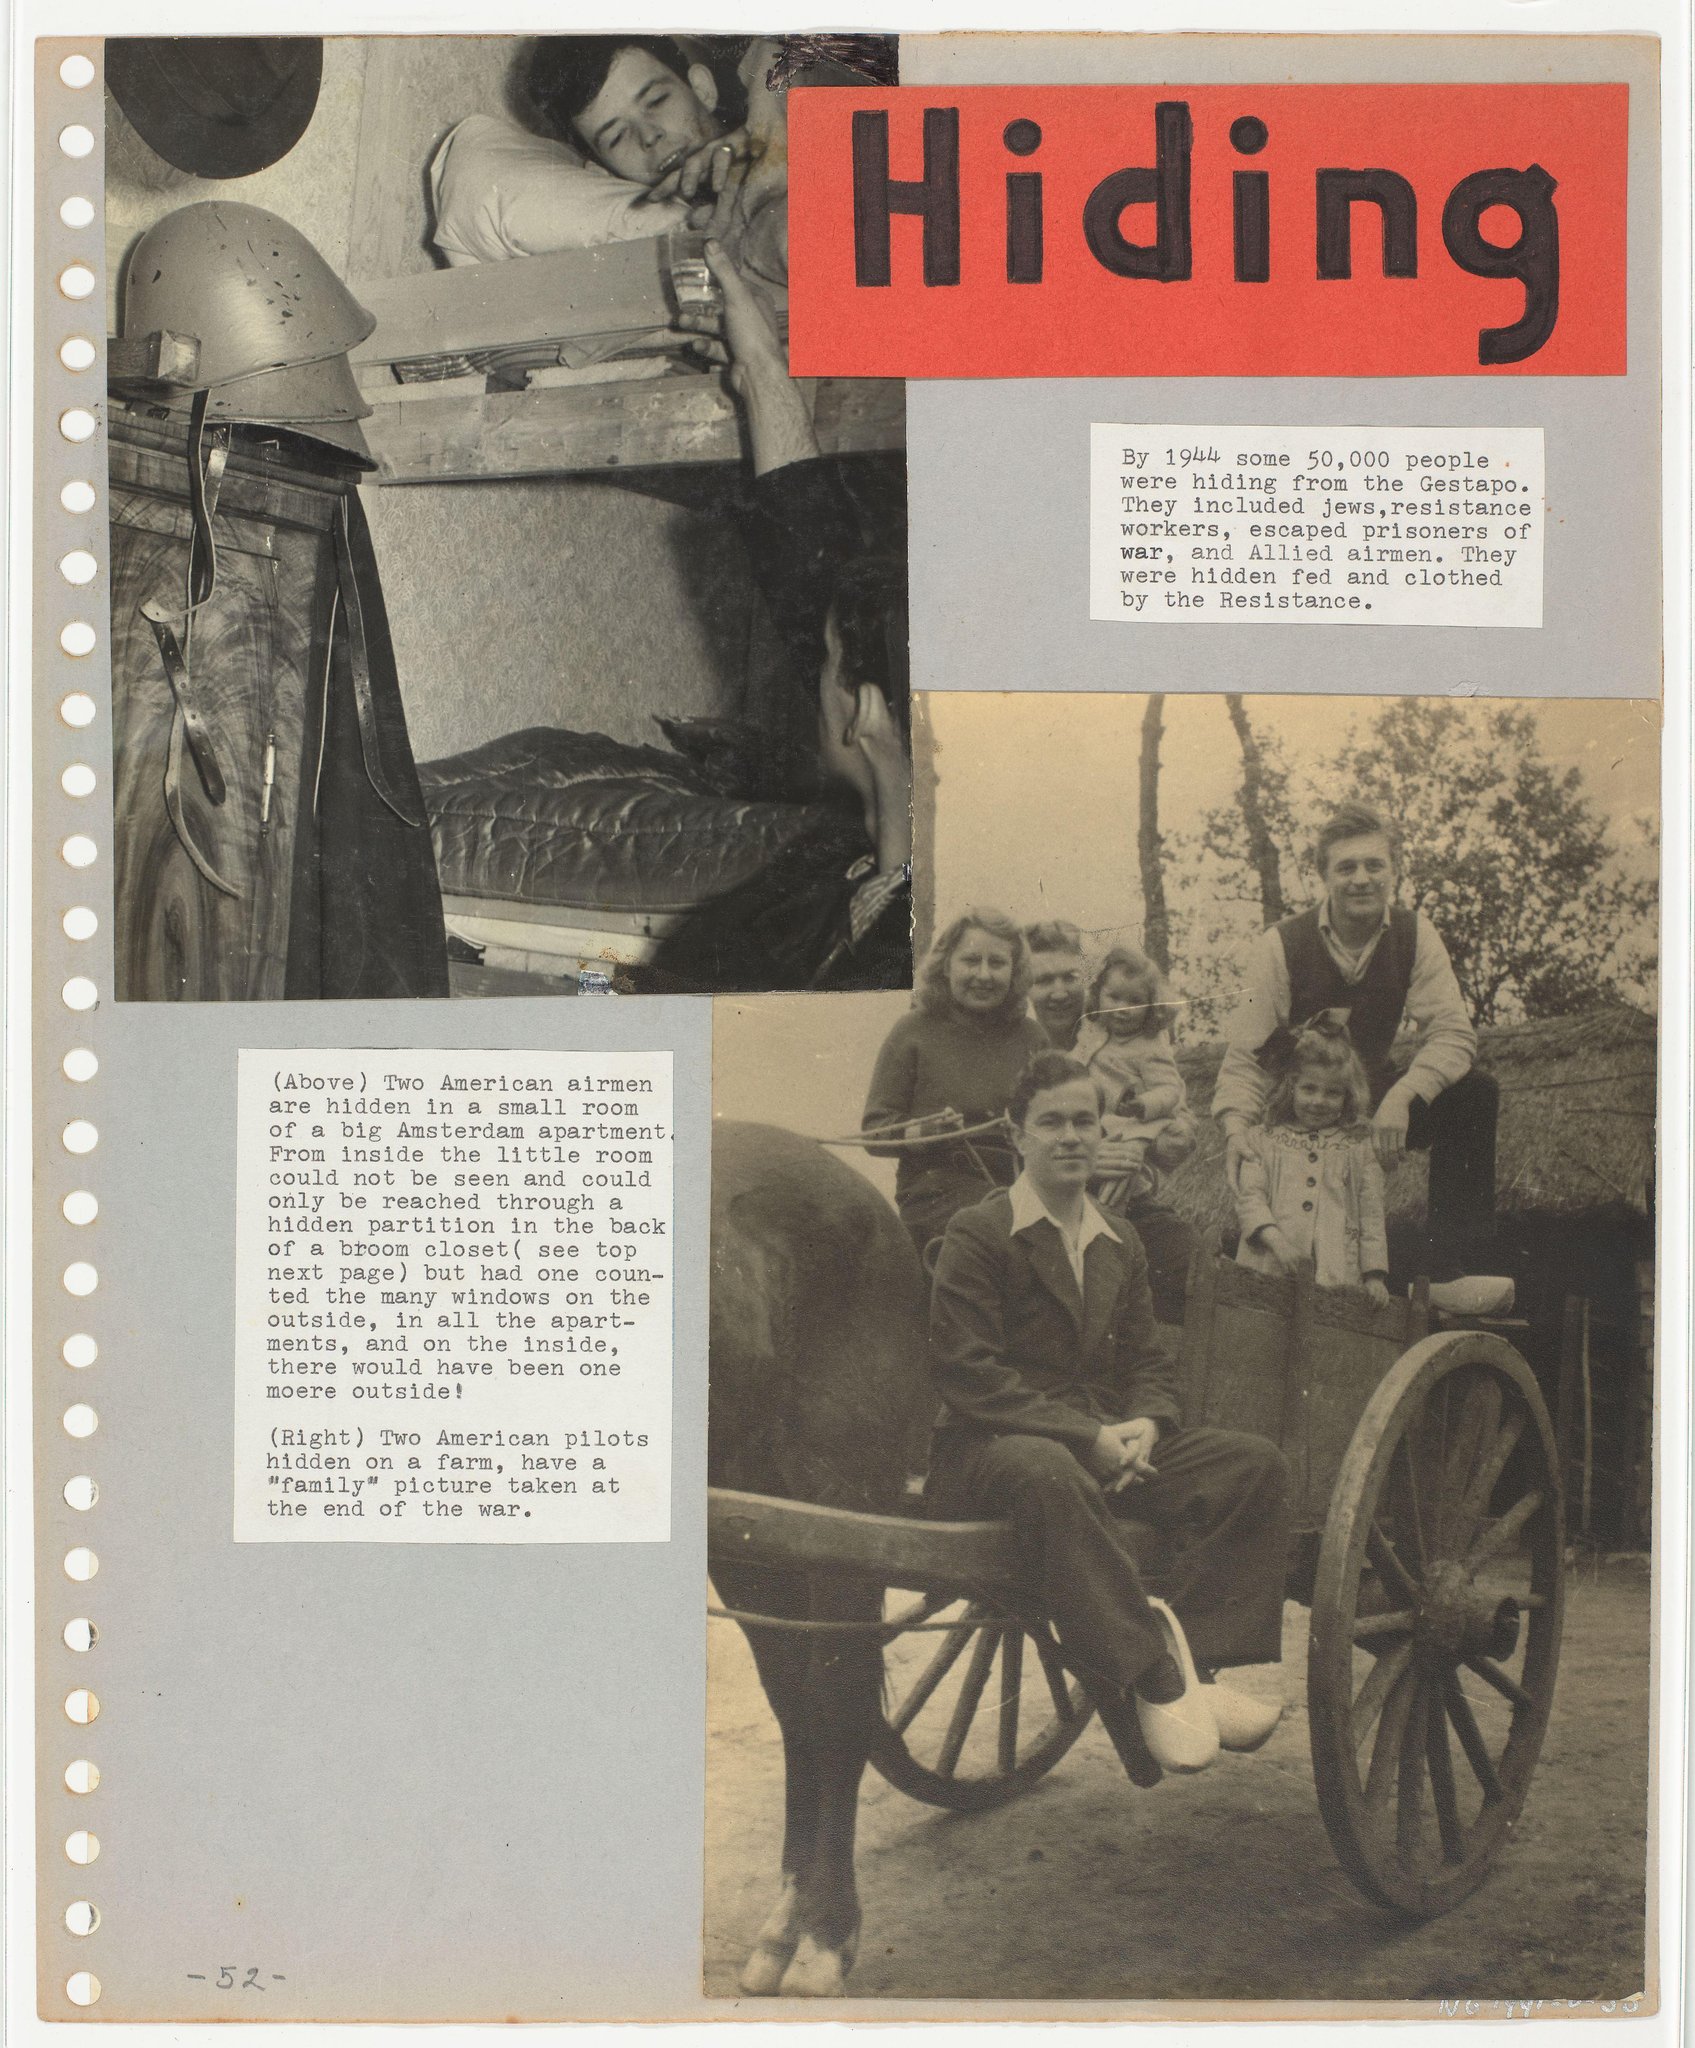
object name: album leaf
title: Ondergedoken Amerikaanse piloten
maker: Anonymous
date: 1944-1945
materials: paper, plastic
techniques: photography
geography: amsterdam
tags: amsterdam, tonny van renterghem, berlin, fritz kahlenberg, underground movement, partisans, netherlands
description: Twee foto's van ondergedoken Amerikaanse piloten. Foto boven: twee Amerikaanse piloten ondergedoken in Amsterdam. Foto onder: twee Amerikaanse piloten ondergedoken bij een familie op een boerderij, zittend op een kar.